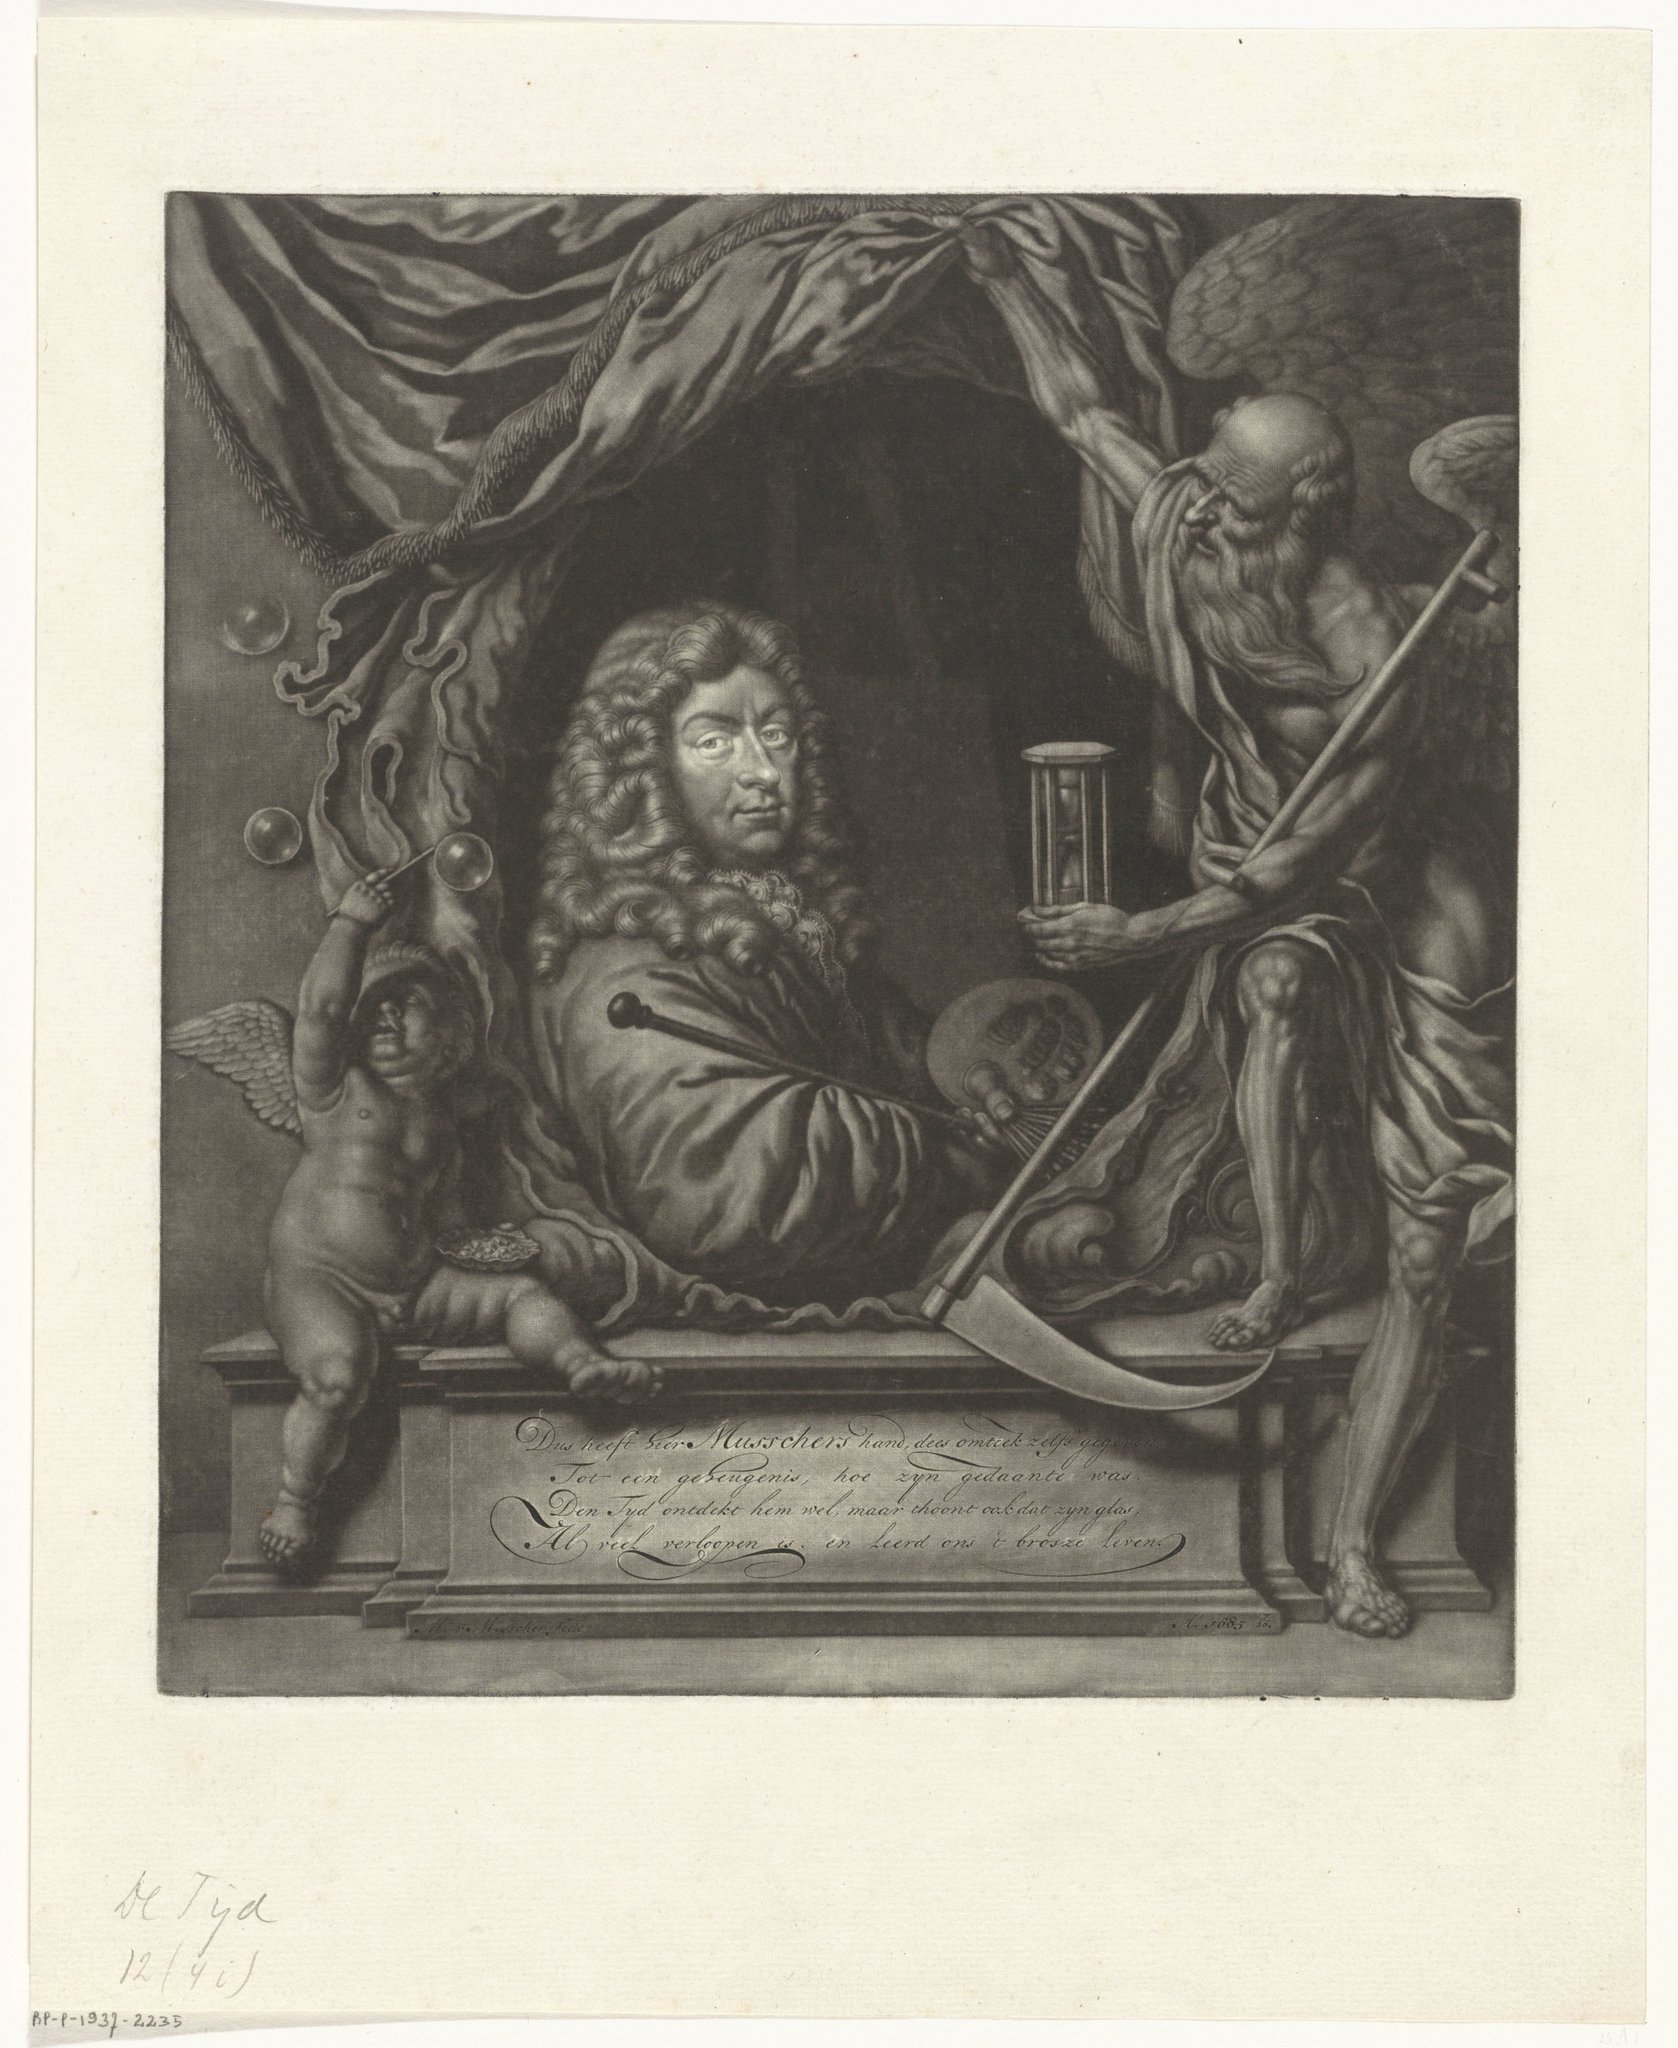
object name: print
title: Zelfportret van Michiel van Musscher in allegorische omlijsting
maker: michiel van musscher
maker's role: draughtsman, painter, print maker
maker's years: 1645-1705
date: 1685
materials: paper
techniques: engraving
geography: northern netherlands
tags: (personifications of) 'vanitas', the vanity of human life; fragilità humana, fugacità delle grandezze & della gloria mondana, meditatione della morte, opera vana, piacere vano, vana gloria, vanità (ripa), portrait, self-portrait of painter, tools, implements of painter, hourglass, father time, man with wings and scythe, (children or putti) blowing bubbles, 'homo bulla' ~ scene symbolizing 'vanitas'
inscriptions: collector's mark: Lugt 2760, poem: ‘Dus heeft hier Musschers hand, dees omtrek zelfs gegeven / Tot een geheugenis, hoe zijn gedaante was / Den Tijd ontdekt hem wel, maar thoont ook dat zijn glas / Al veel verloopen is, en keerd ons t brosze leven.’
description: De schilder, prentmaker en tekenaar Michiel van Musscher met een palet, schildersstok en penselen in de hand. Achter hem staat een schildersezel. Zijn portret is omringd door allegorische symbolen - Vader Tijd, een zandloper en zeepbellen. De schildersattributen en de symbolen verwijzen naar de vergankelijke tijd en de onsterfelijkheid van de kunstenaar door middel van zijn roem. Het vers op het tablet vermeldt dat vader Tijd het doek licht om de grootheid van de schilder te onthullen, maar verwijst tevens naar de zandloper die aangeeft dat zijn leven al gedeeltelijk voorbij is.